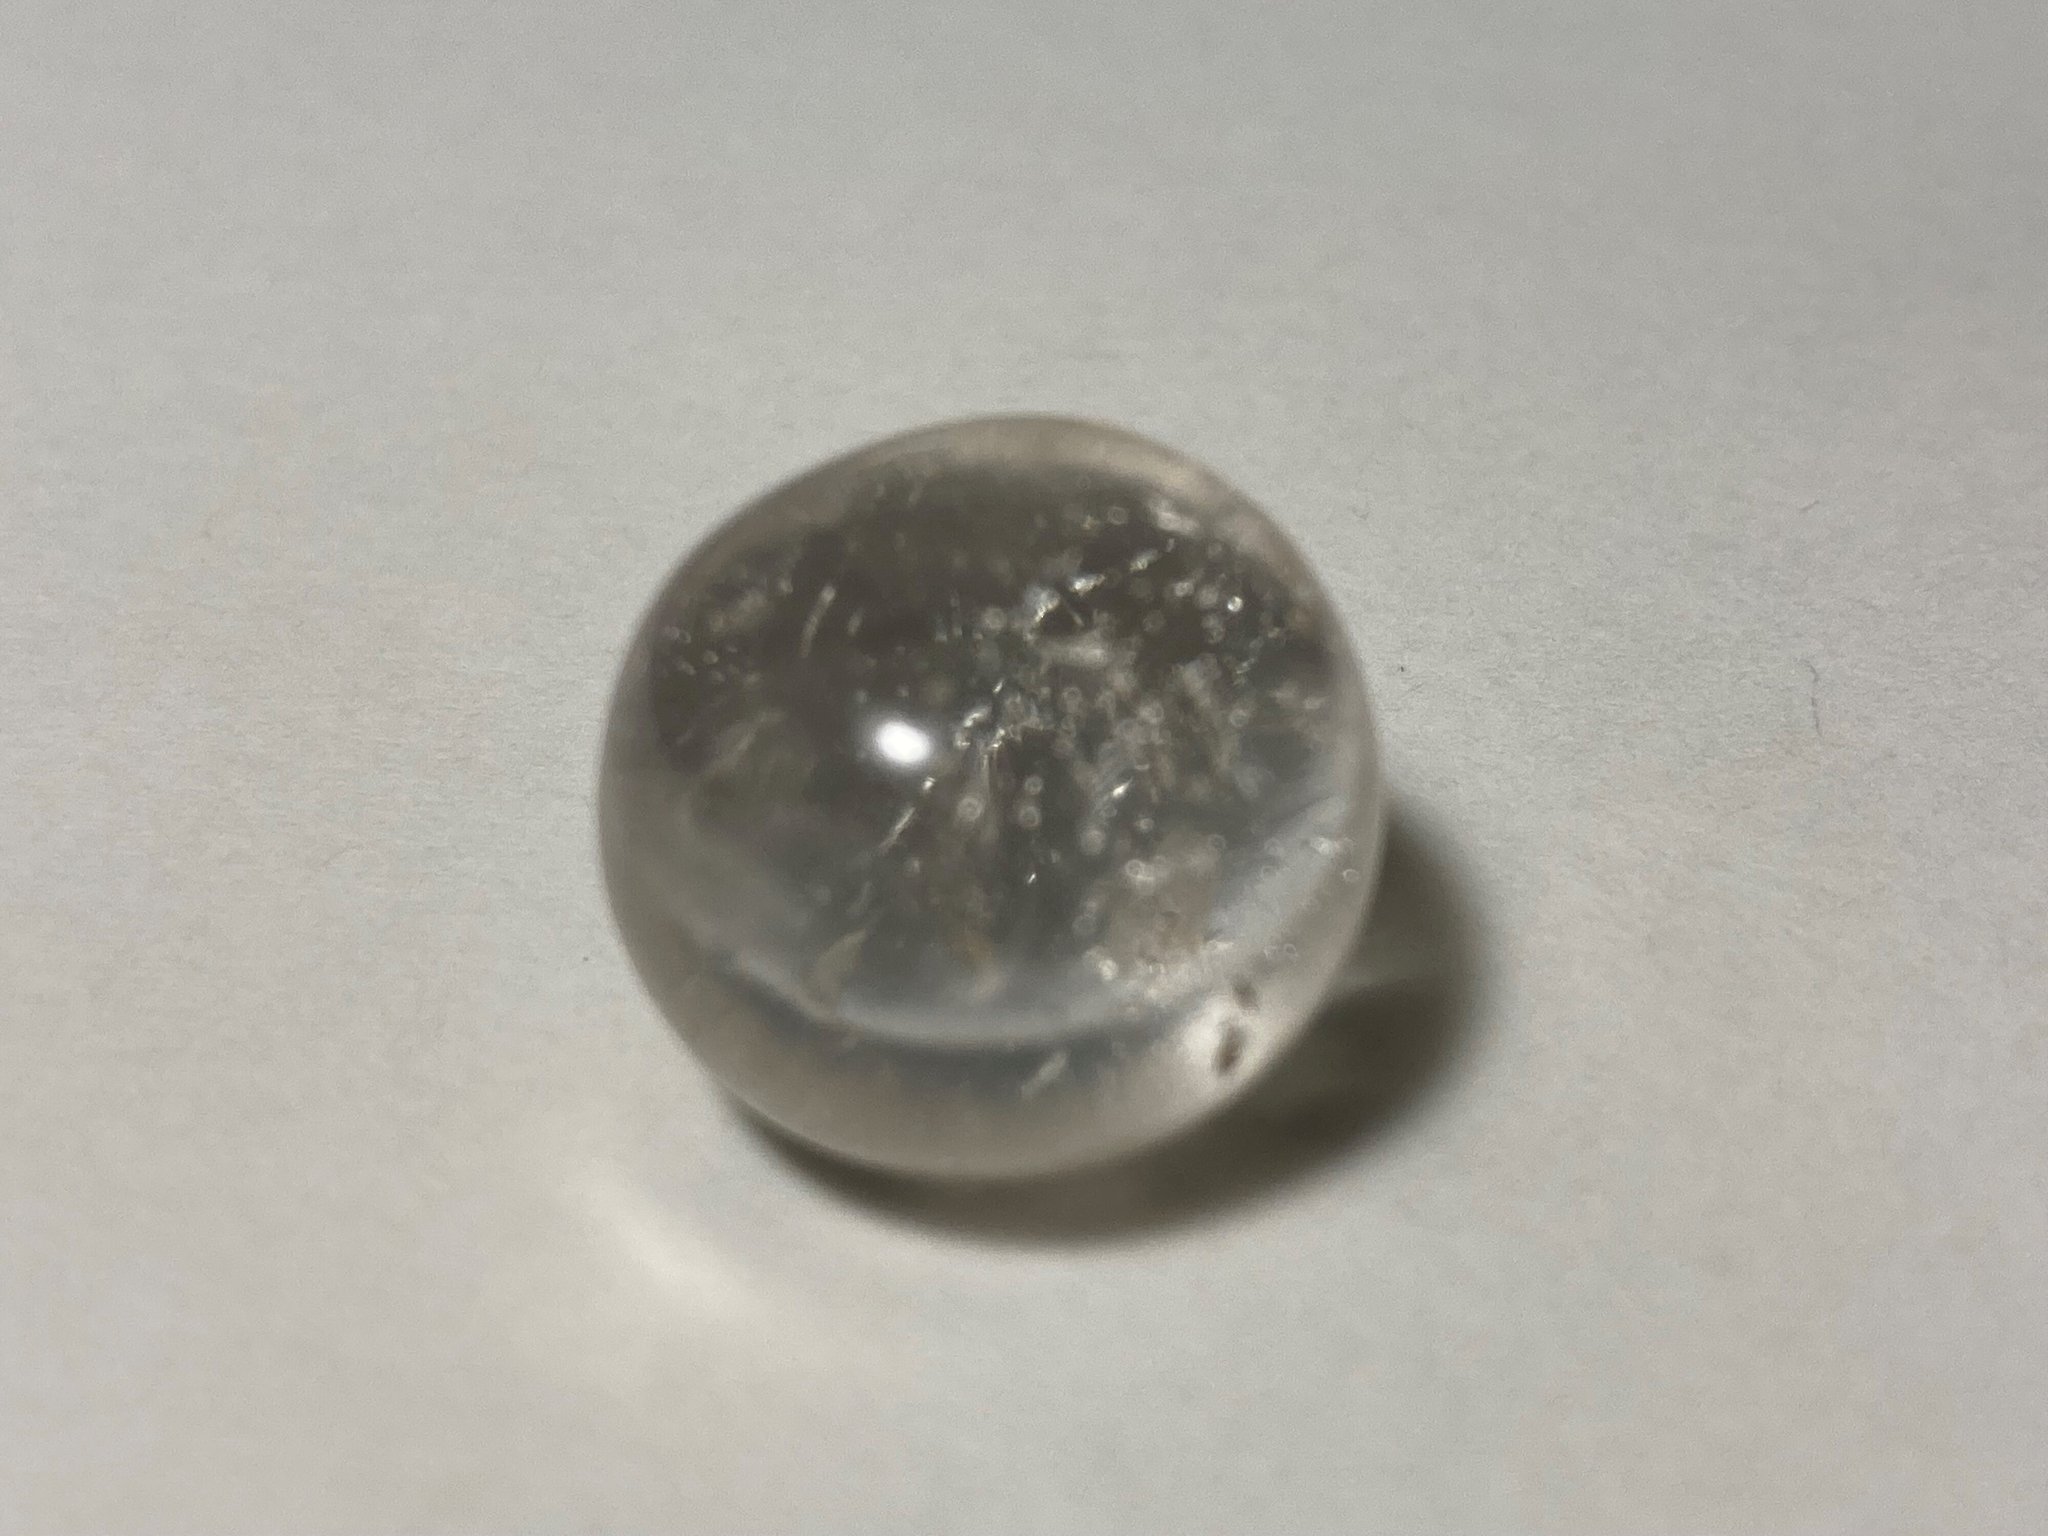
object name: game piece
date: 701-1300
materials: quartz, stone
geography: iran